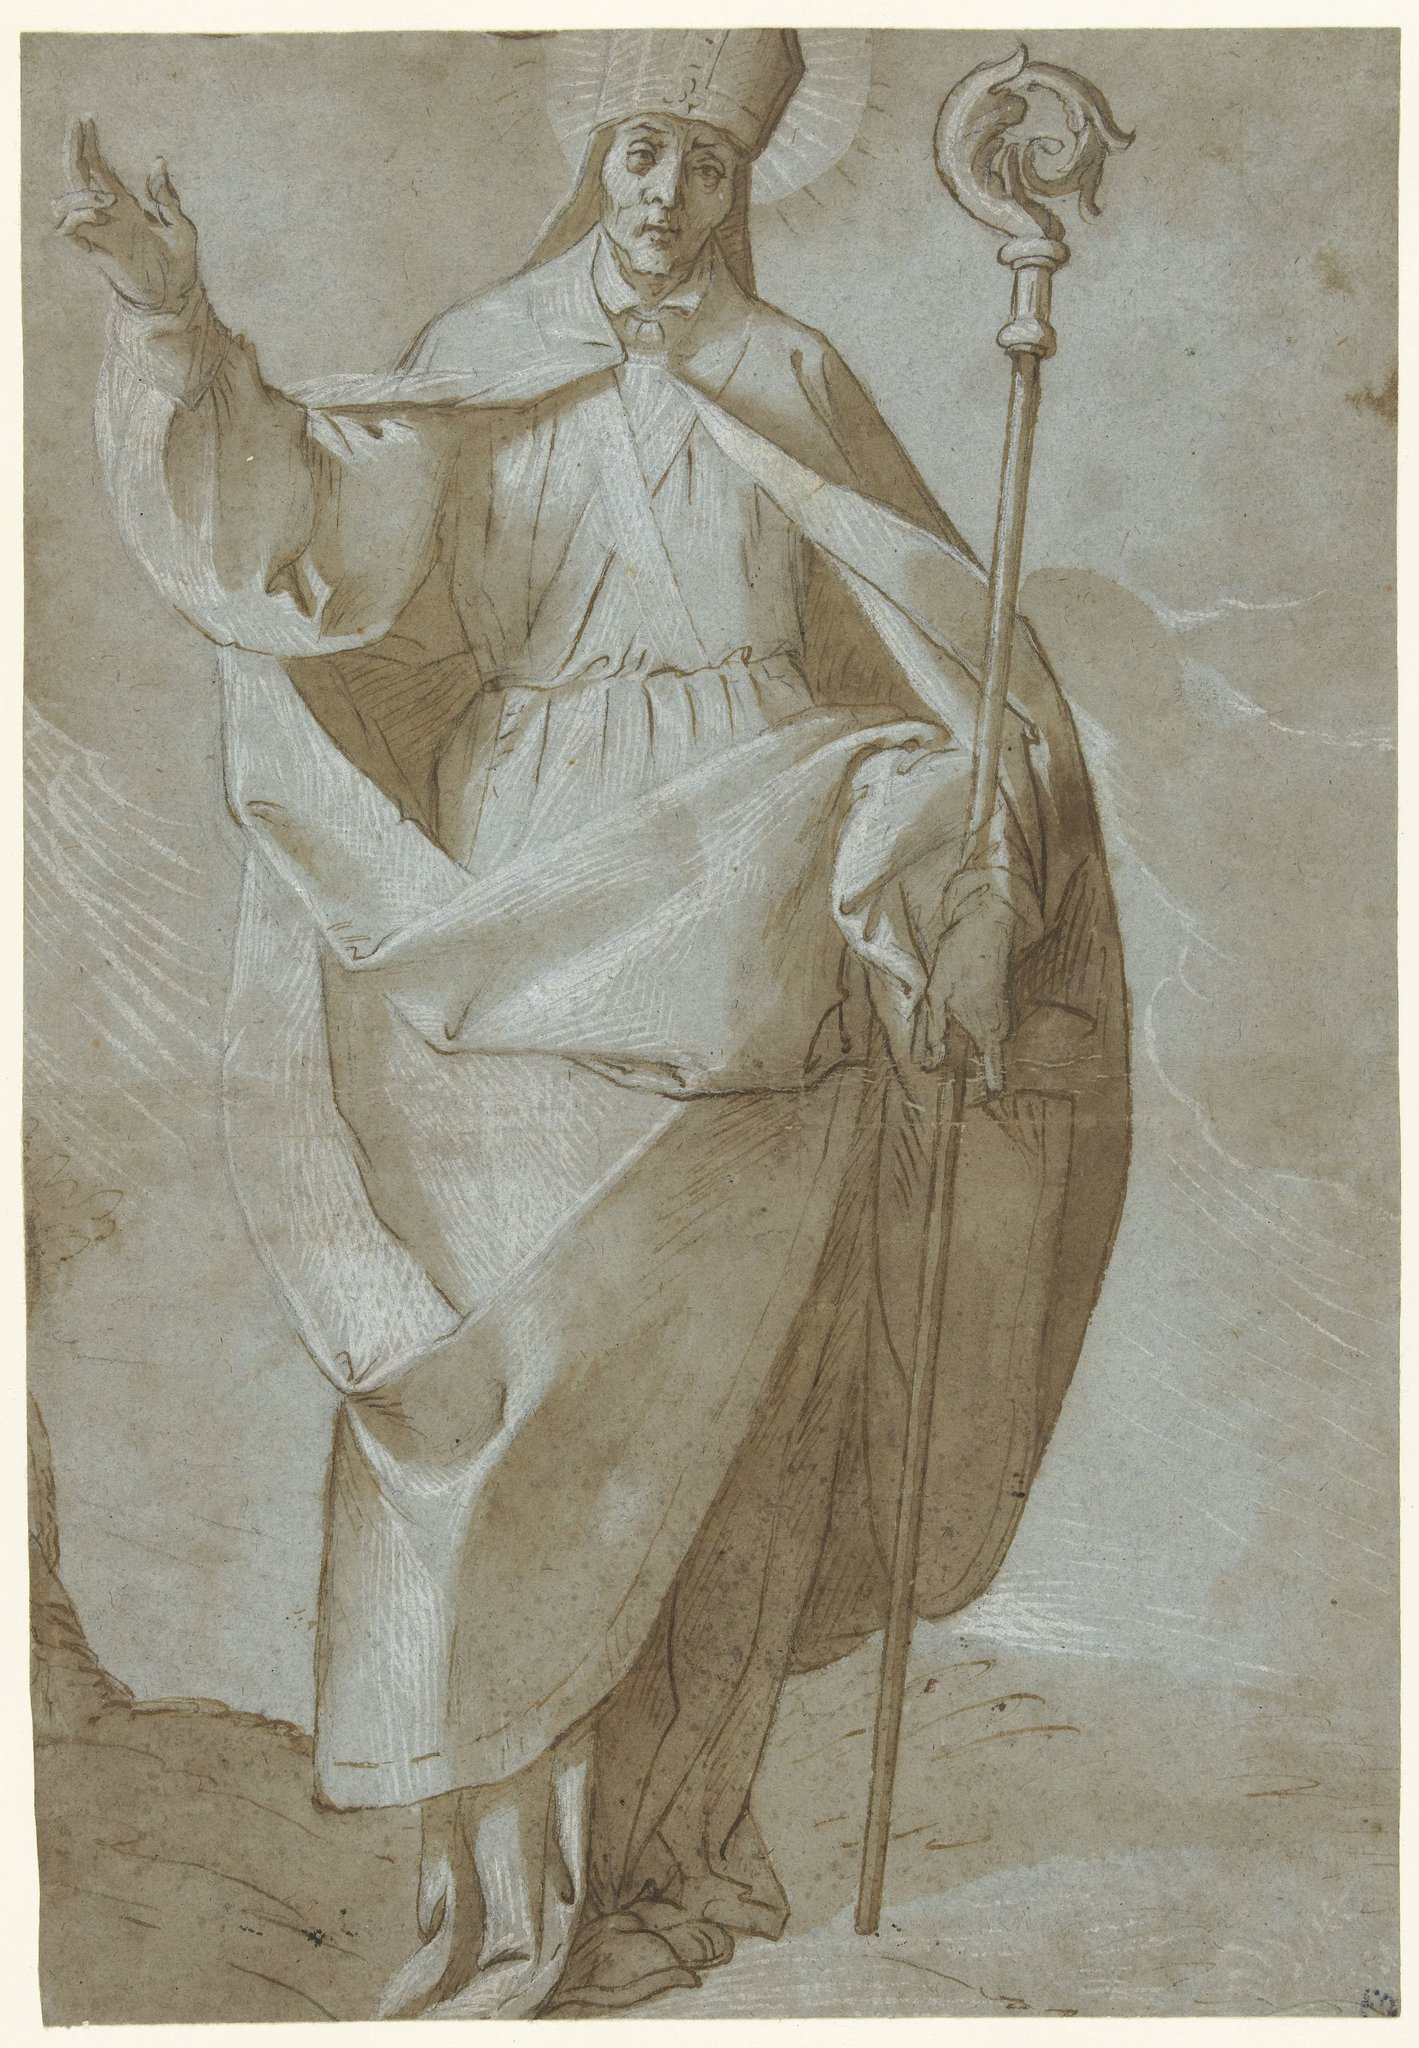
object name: design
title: Heilige Abbondio met mijter en staf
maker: pier francesco morazzone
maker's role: painter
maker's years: 1571-1626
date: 1583-1626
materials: chalk, ink, paper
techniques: brush, pen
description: Ontwerp voor een vaandel in de Dom te Como.